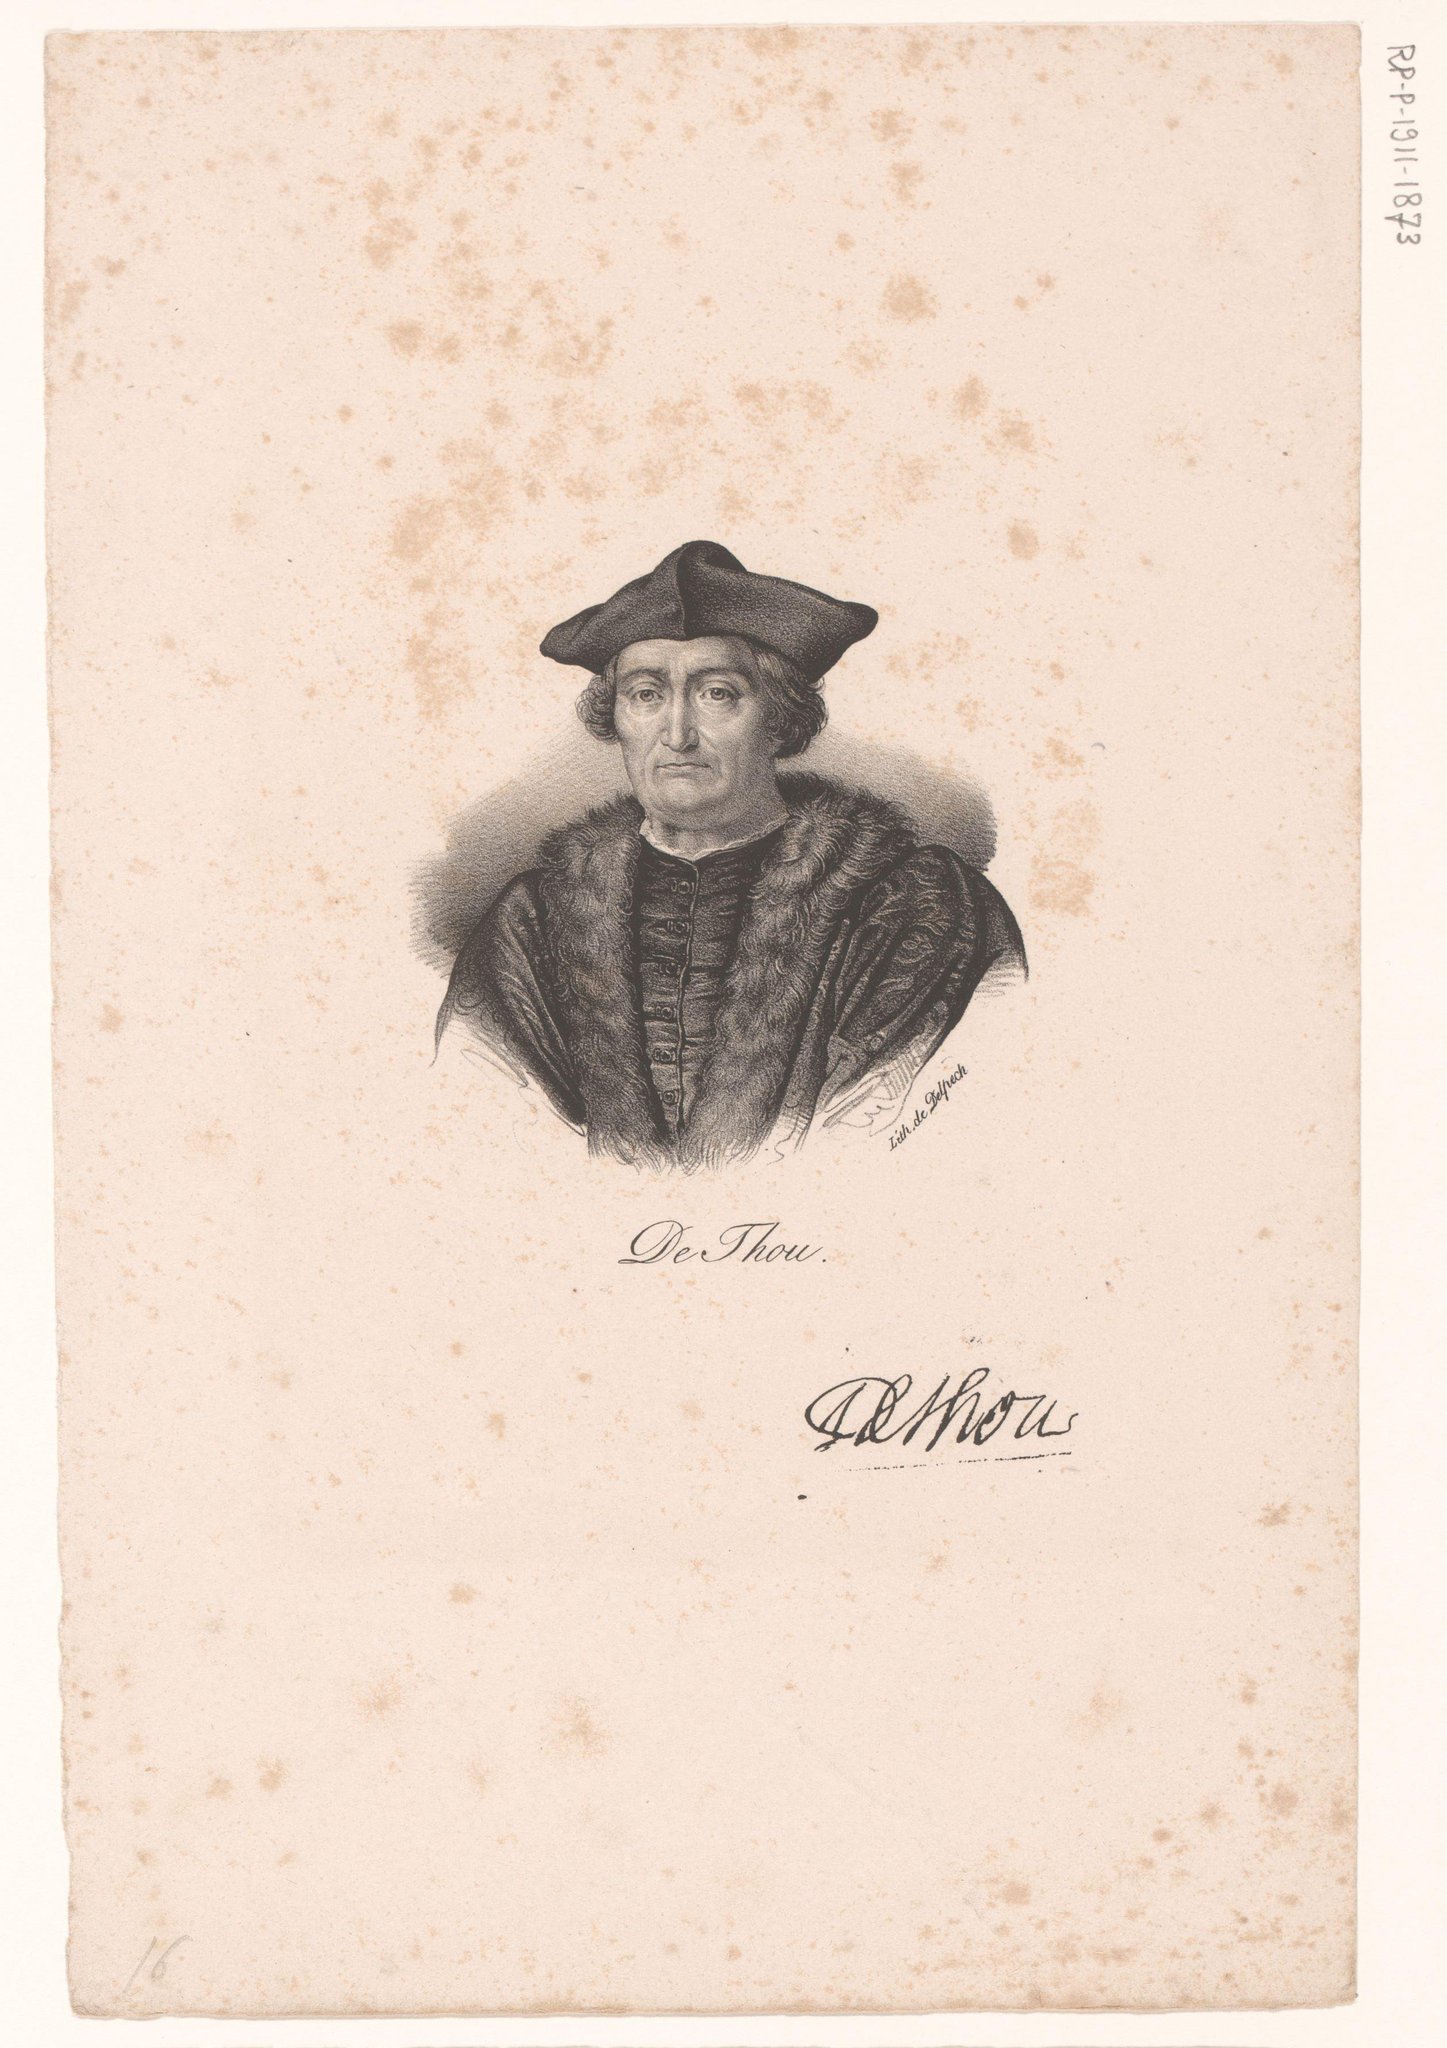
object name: print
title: De Thou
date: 1818-1842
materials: paper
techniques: lithograph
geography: paris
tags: politician, historical persons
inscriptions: collector's mark: Lugt 2228a